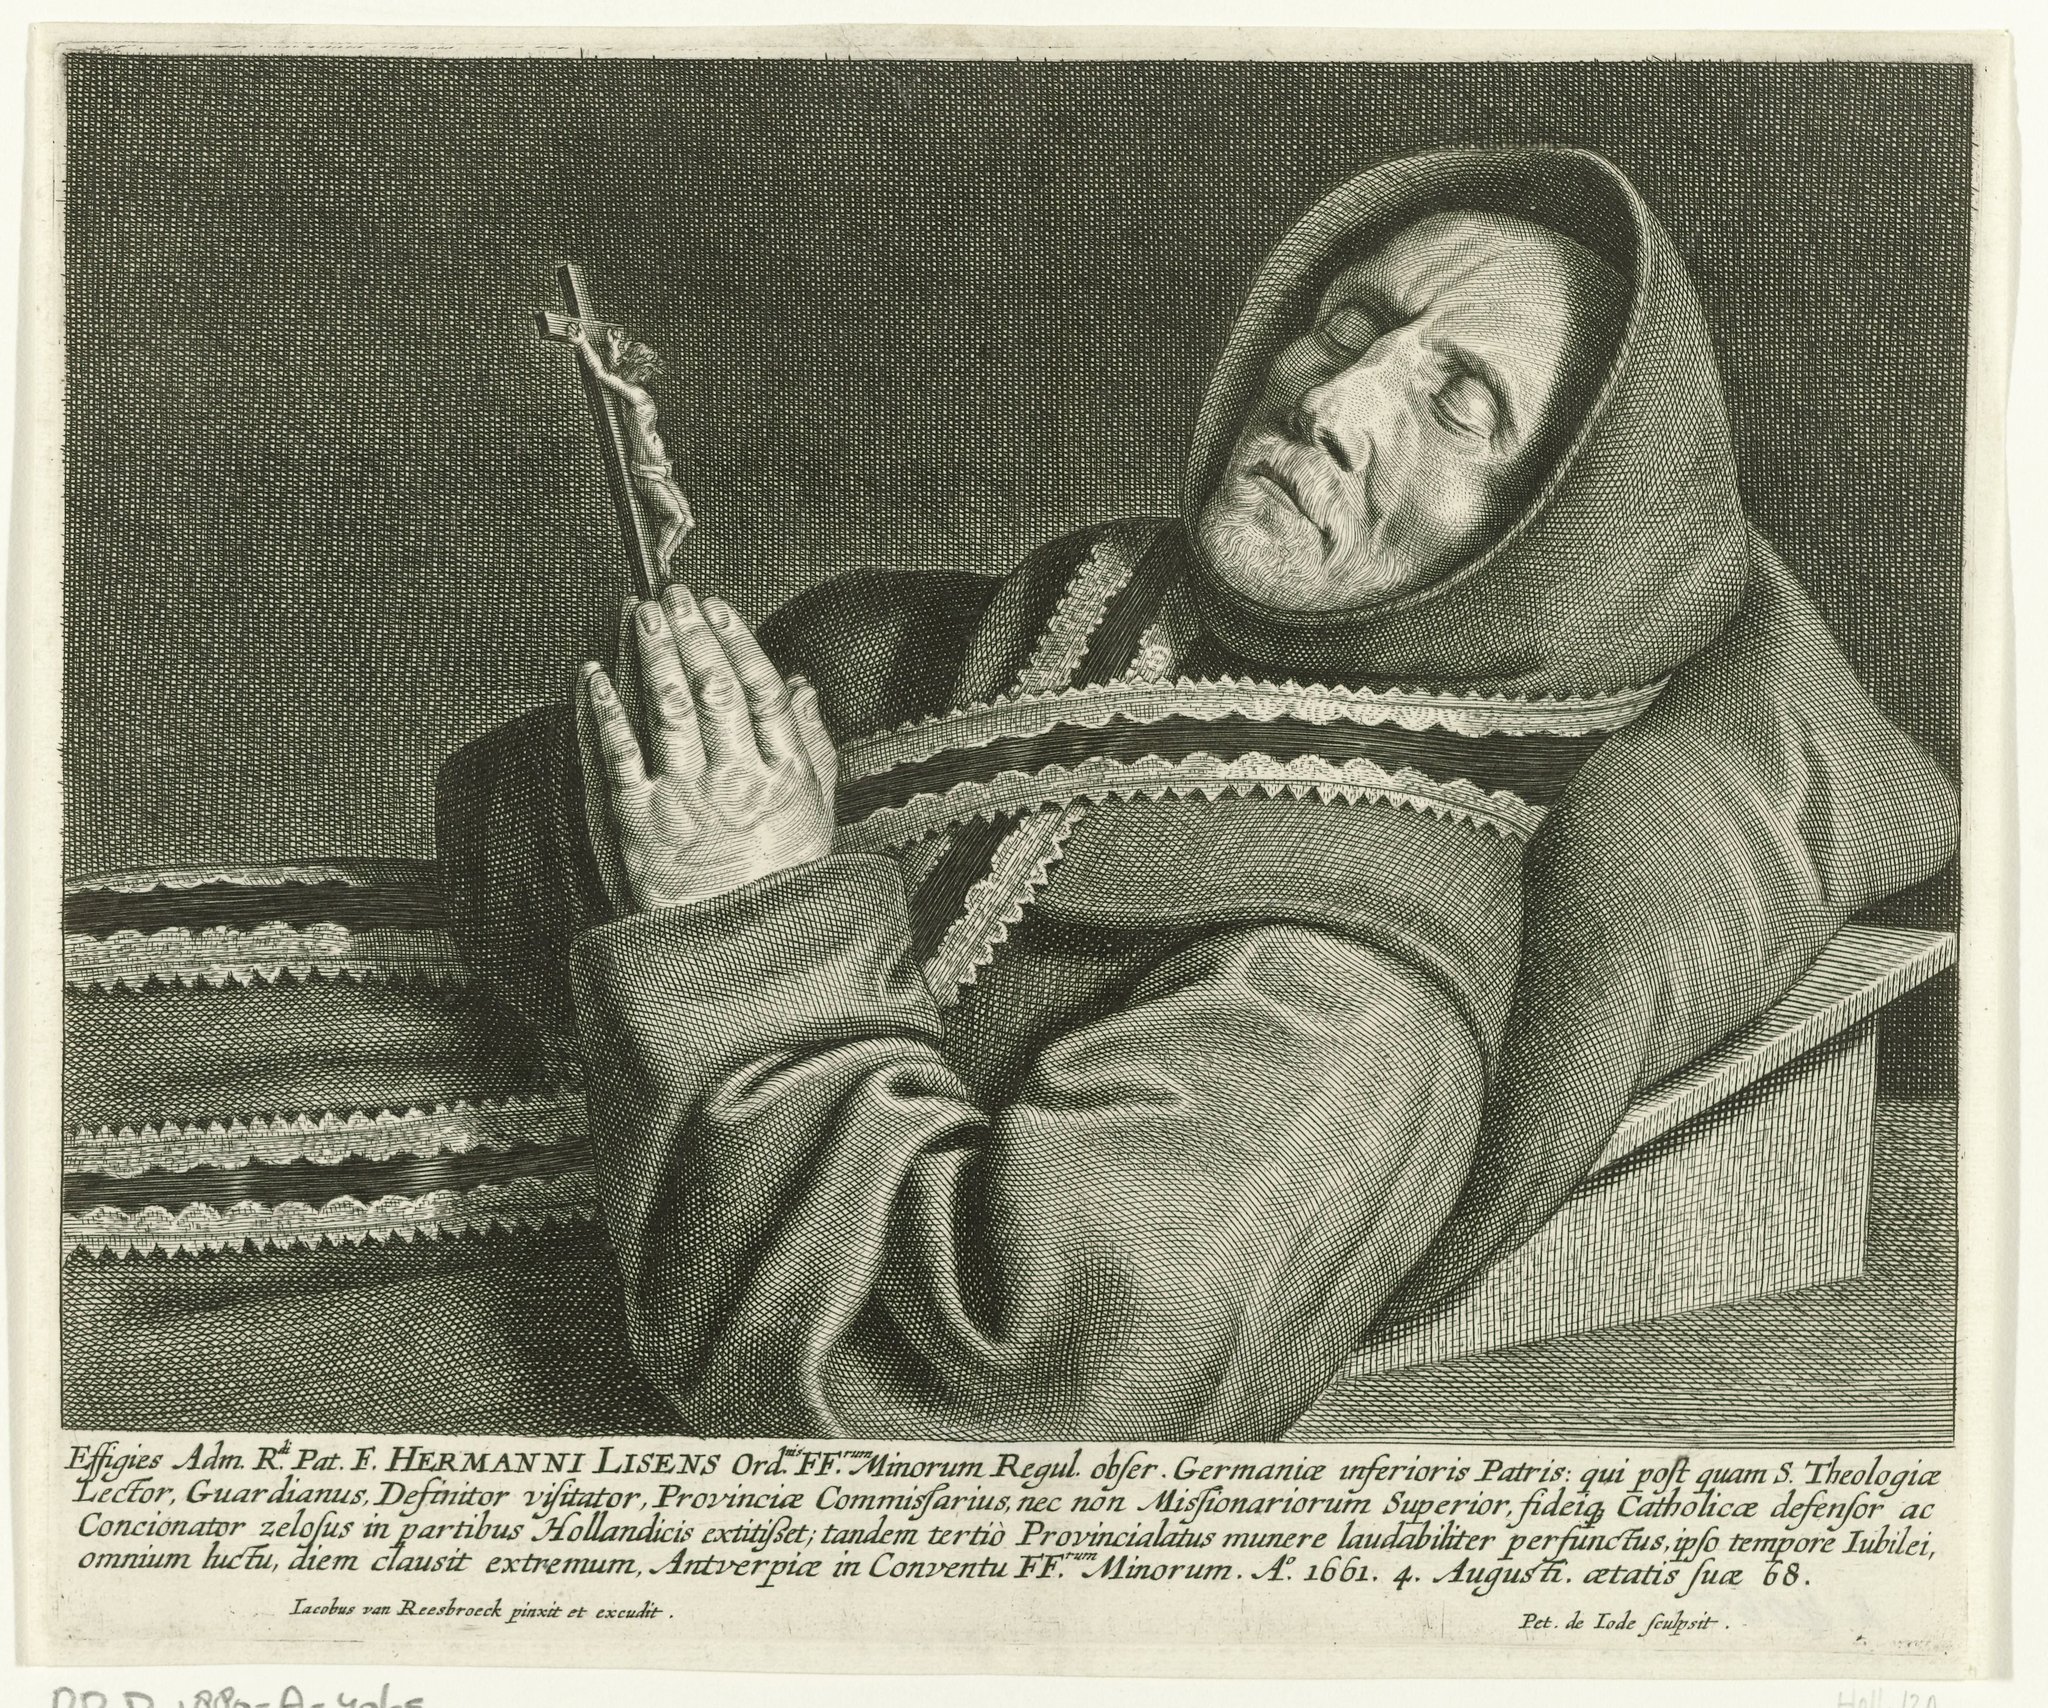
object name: print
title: Herman Lisens, opgebaard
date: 1628-1670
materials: paper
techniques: engraving, etching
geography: antwerp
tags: herman lisens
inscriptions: collector's mark: Lugt 2228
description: De minnebroeder Herman Lisens, op 68-jarige leeftijd, opgebaard. Hij draagt zijn geestelijk gewaad en houdt een crucifix in zijn gevouwen handen. In de marge een vierregelig onderschrift in het Latijn.